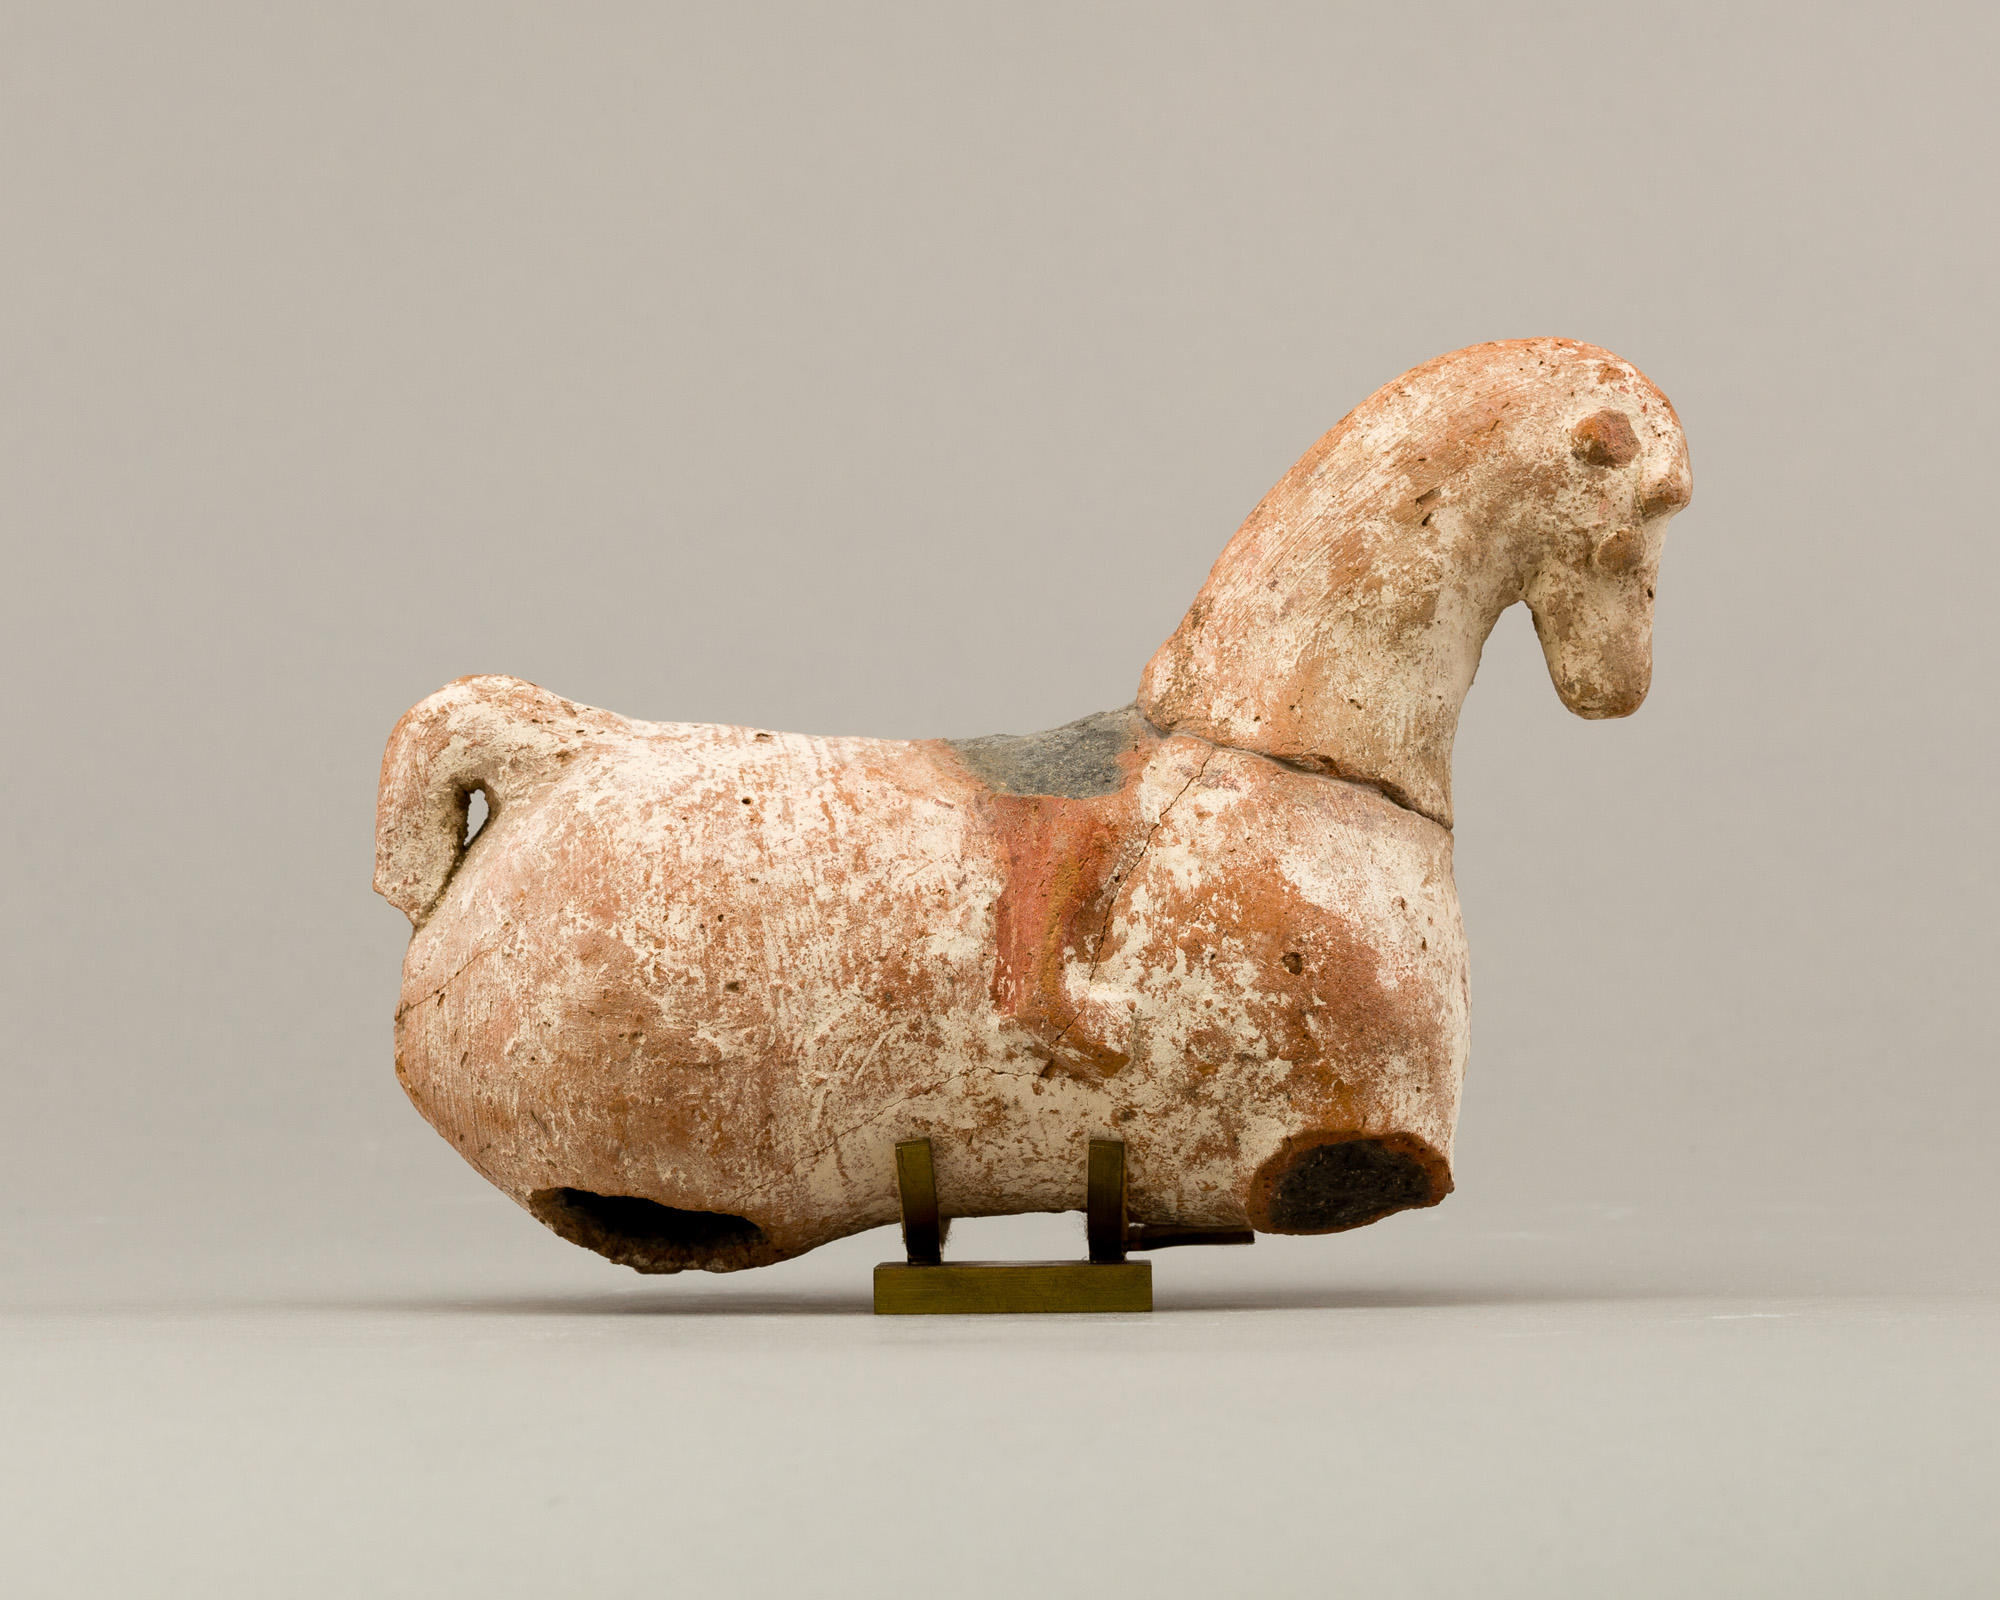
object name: figurine, horse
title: Horse Figurine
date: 306-30 BCE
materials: paint, pottery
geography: egypt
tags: horses